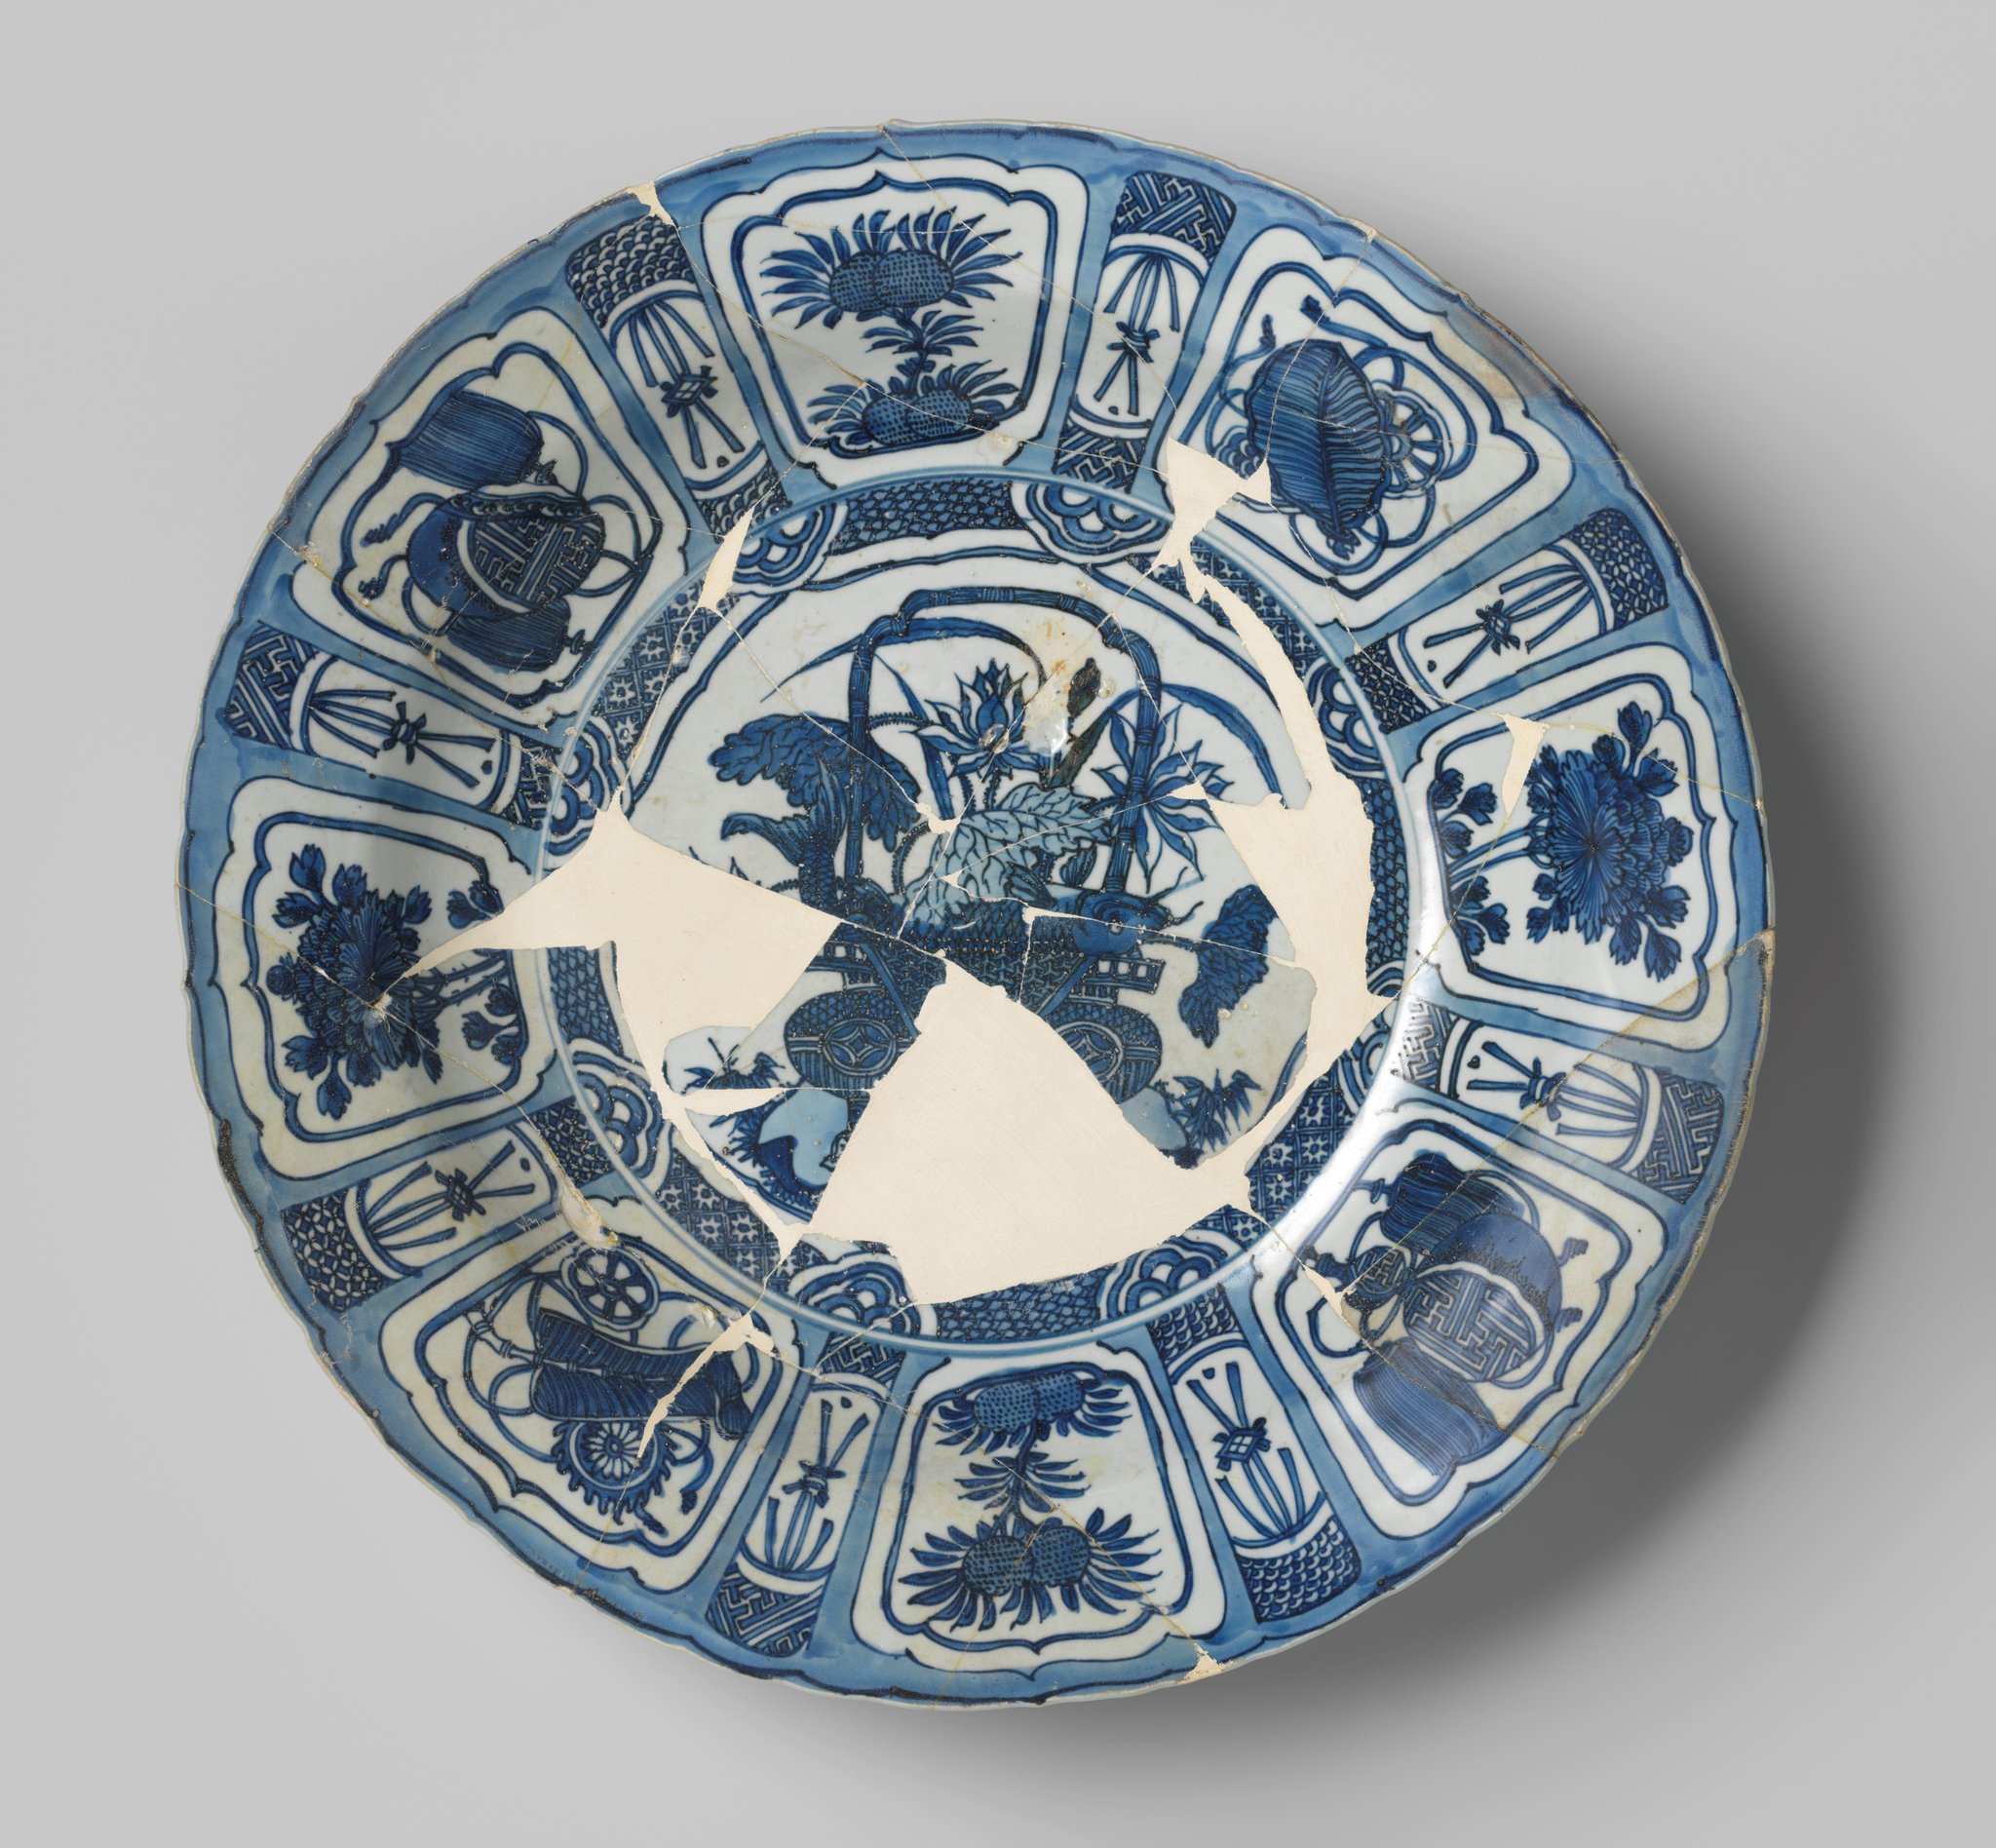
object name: platter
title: Schotel uit V.O.C.-schip de 'Witte Leeuw'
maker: Anonymous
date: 1613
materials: bone china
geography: jingdezhen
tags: verenigde oostindische compagnie, sint-helena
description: Schotel uit V.O.C.-schip de 'Witte Leeuw', 90% aanwezig. De scherf is glasachtig wit en het glazuur is blauwgetint. De bodem is ongeglazuurd en de voetring is gefacetteerd en v-vormig. Er is weinig ovenzand aangetroffen. De lip is geschulpt. Lampetschotel. De schotel is aangevuld.